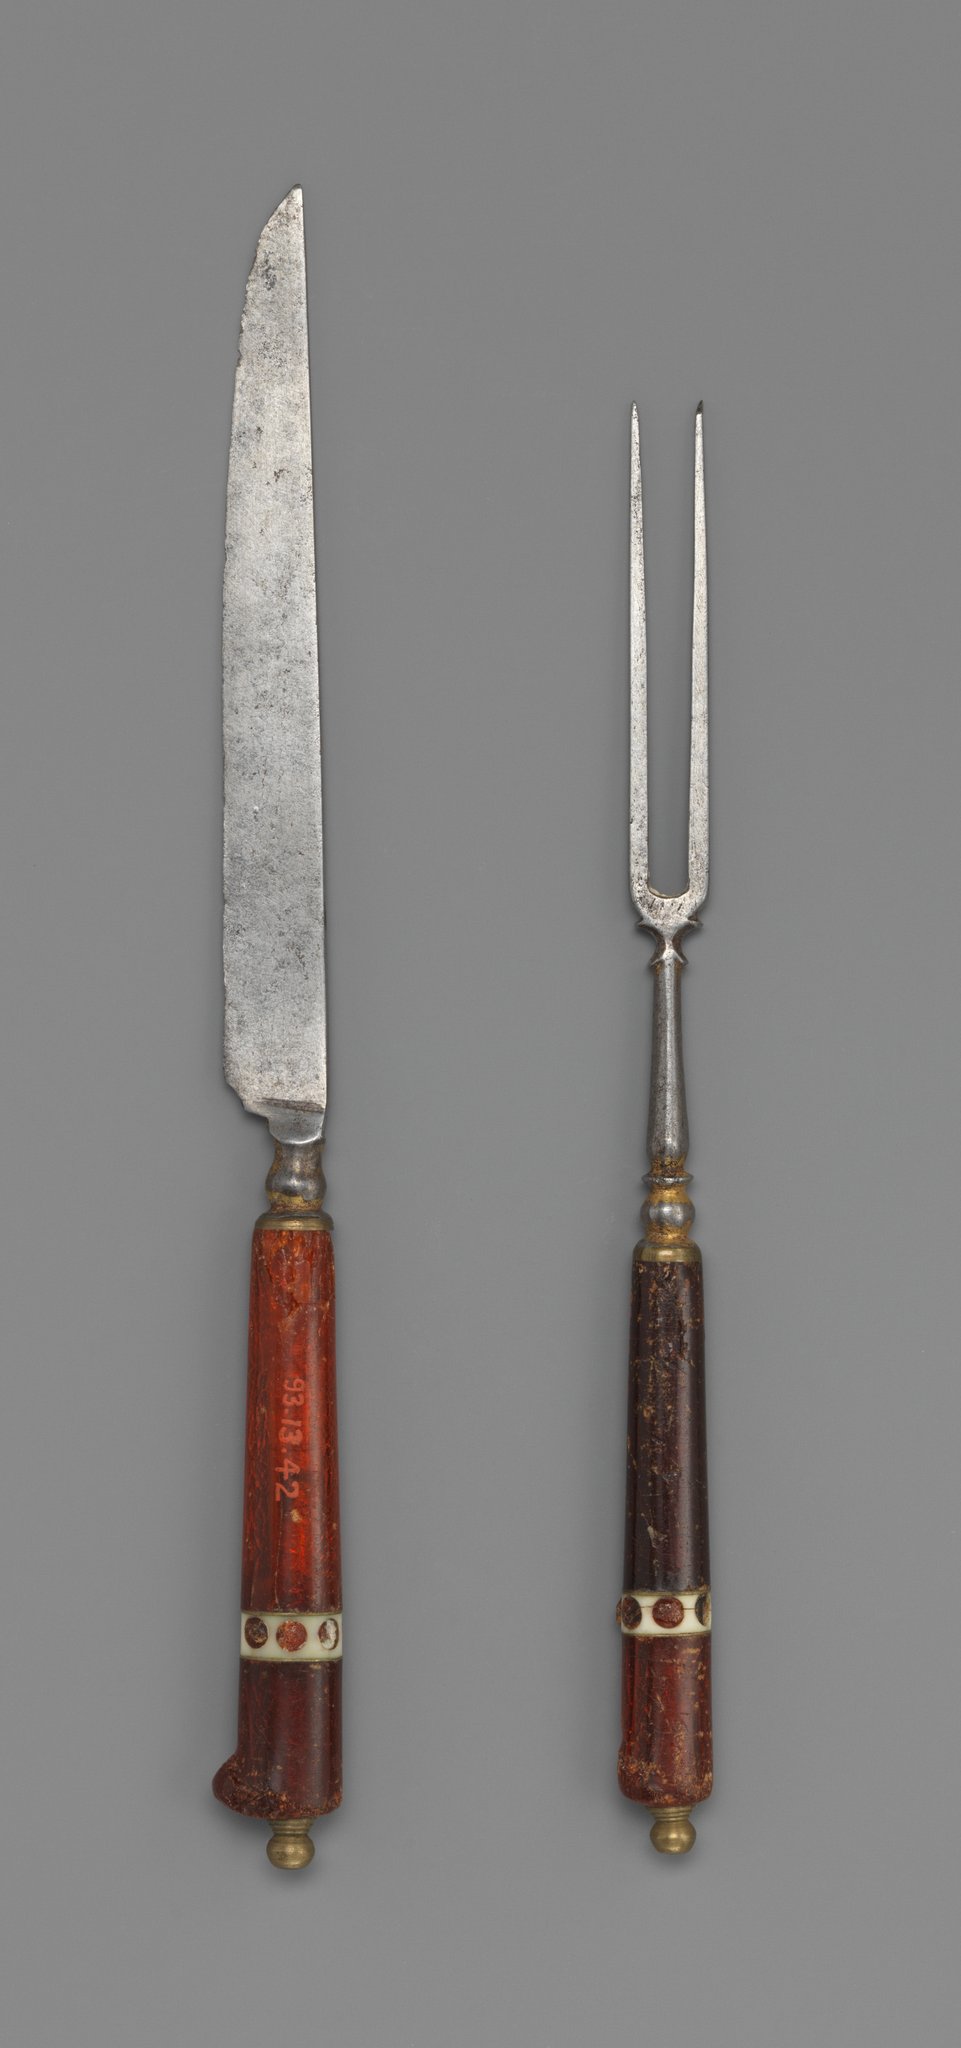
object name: table knife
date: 1601-1700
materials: amber, brass, steel